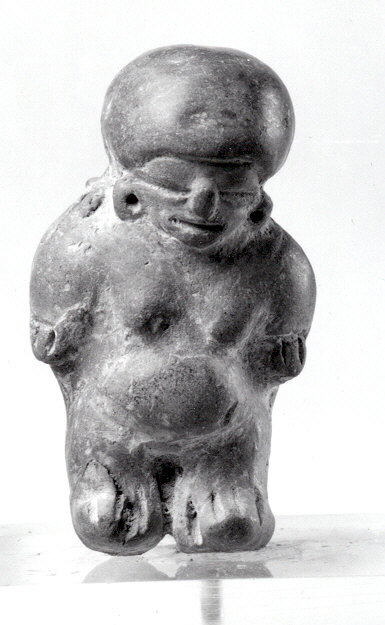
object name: figure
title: Ceramic Figure Pendant (?)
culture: chorrera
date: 1000-201 BCE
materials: ceramic, pigment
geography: ecuador